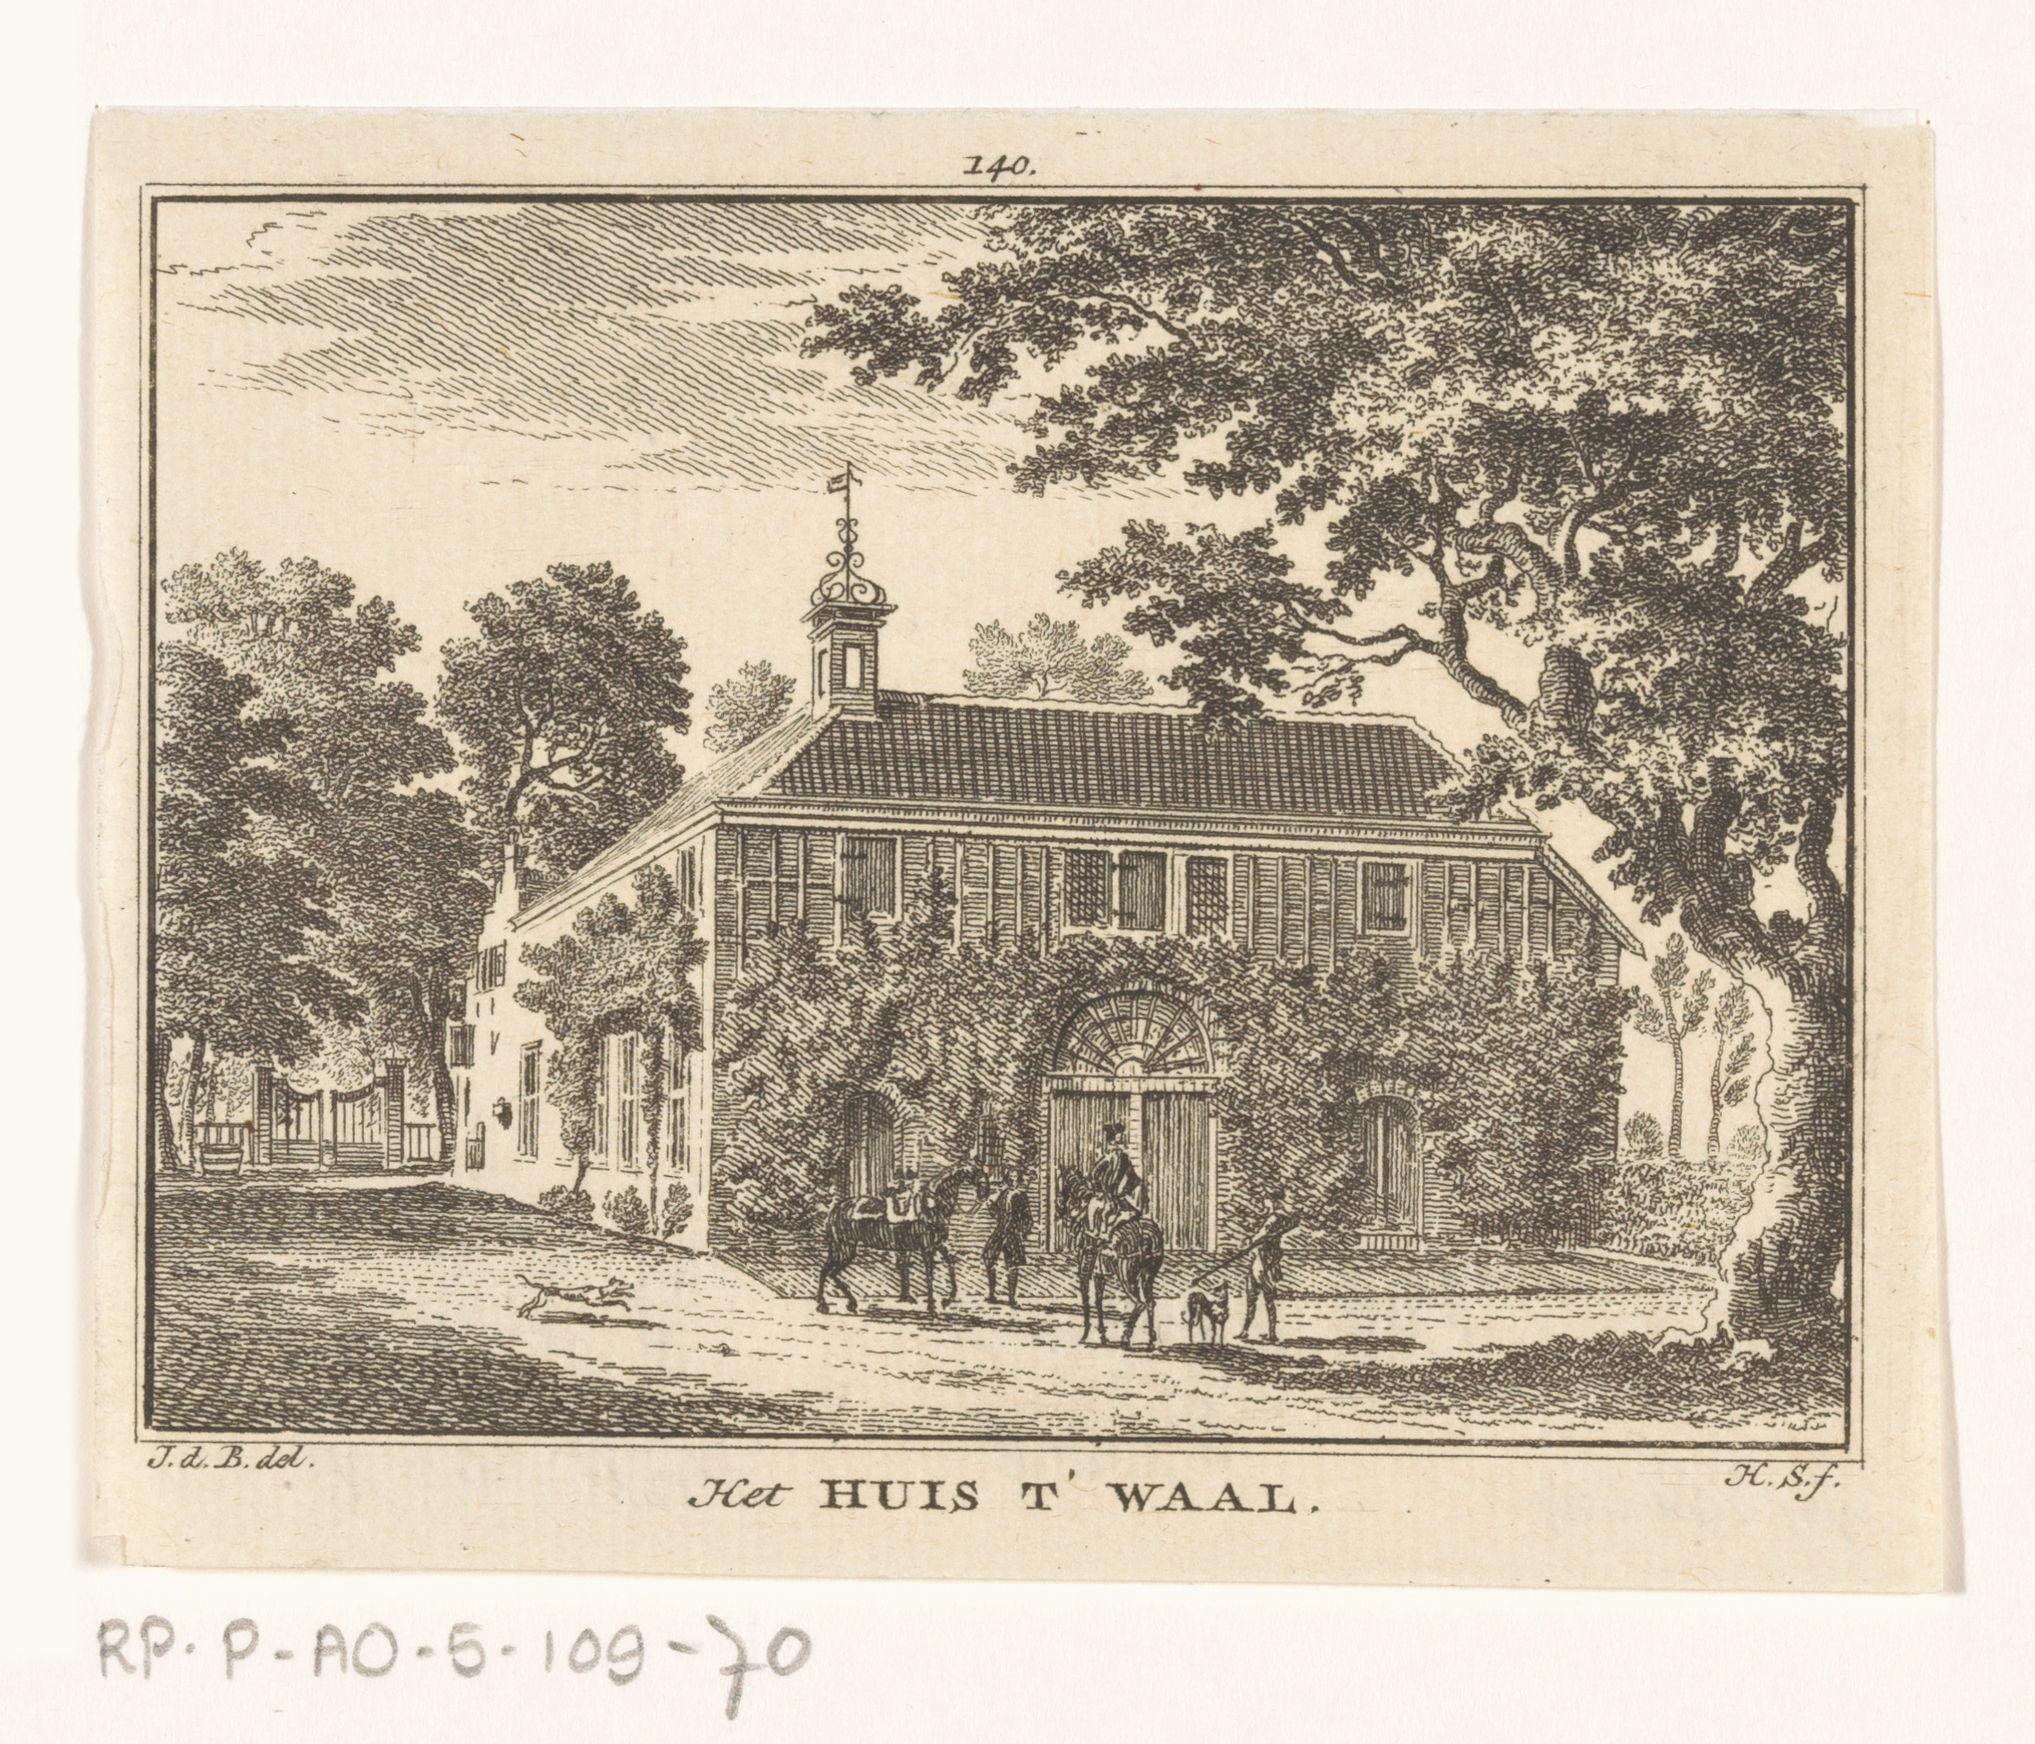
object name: print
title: Het huis t' Waal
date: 1773-1792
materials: paper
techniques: engraving, etching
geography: haarlem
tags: country-house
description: Prent ook gebruikt in: Het verheerlykt Nederland of kabinet van hedendaagsche gezigten van steden, dorpen (…). 9 delen. Amsterdam: Isaak Tirion en weduwe Isaak Tirion, 1745-1774, dl. 7, 8 of 9 (weduwe Isaak Tirion, 1773-1774), ill. 140. Of in: Nederlandsche tafereelen; of eene keurige verzameling van negen honderd fraaije gezigten van steden, dorpen, sloten, oudheden (….). 9 delen. Amsterdam: Jan de Groot, 1792, dl. 7, 8 of 9, ill. 140. Uit welke druk het huidige exemplaar precies komt is niet na te gaan.